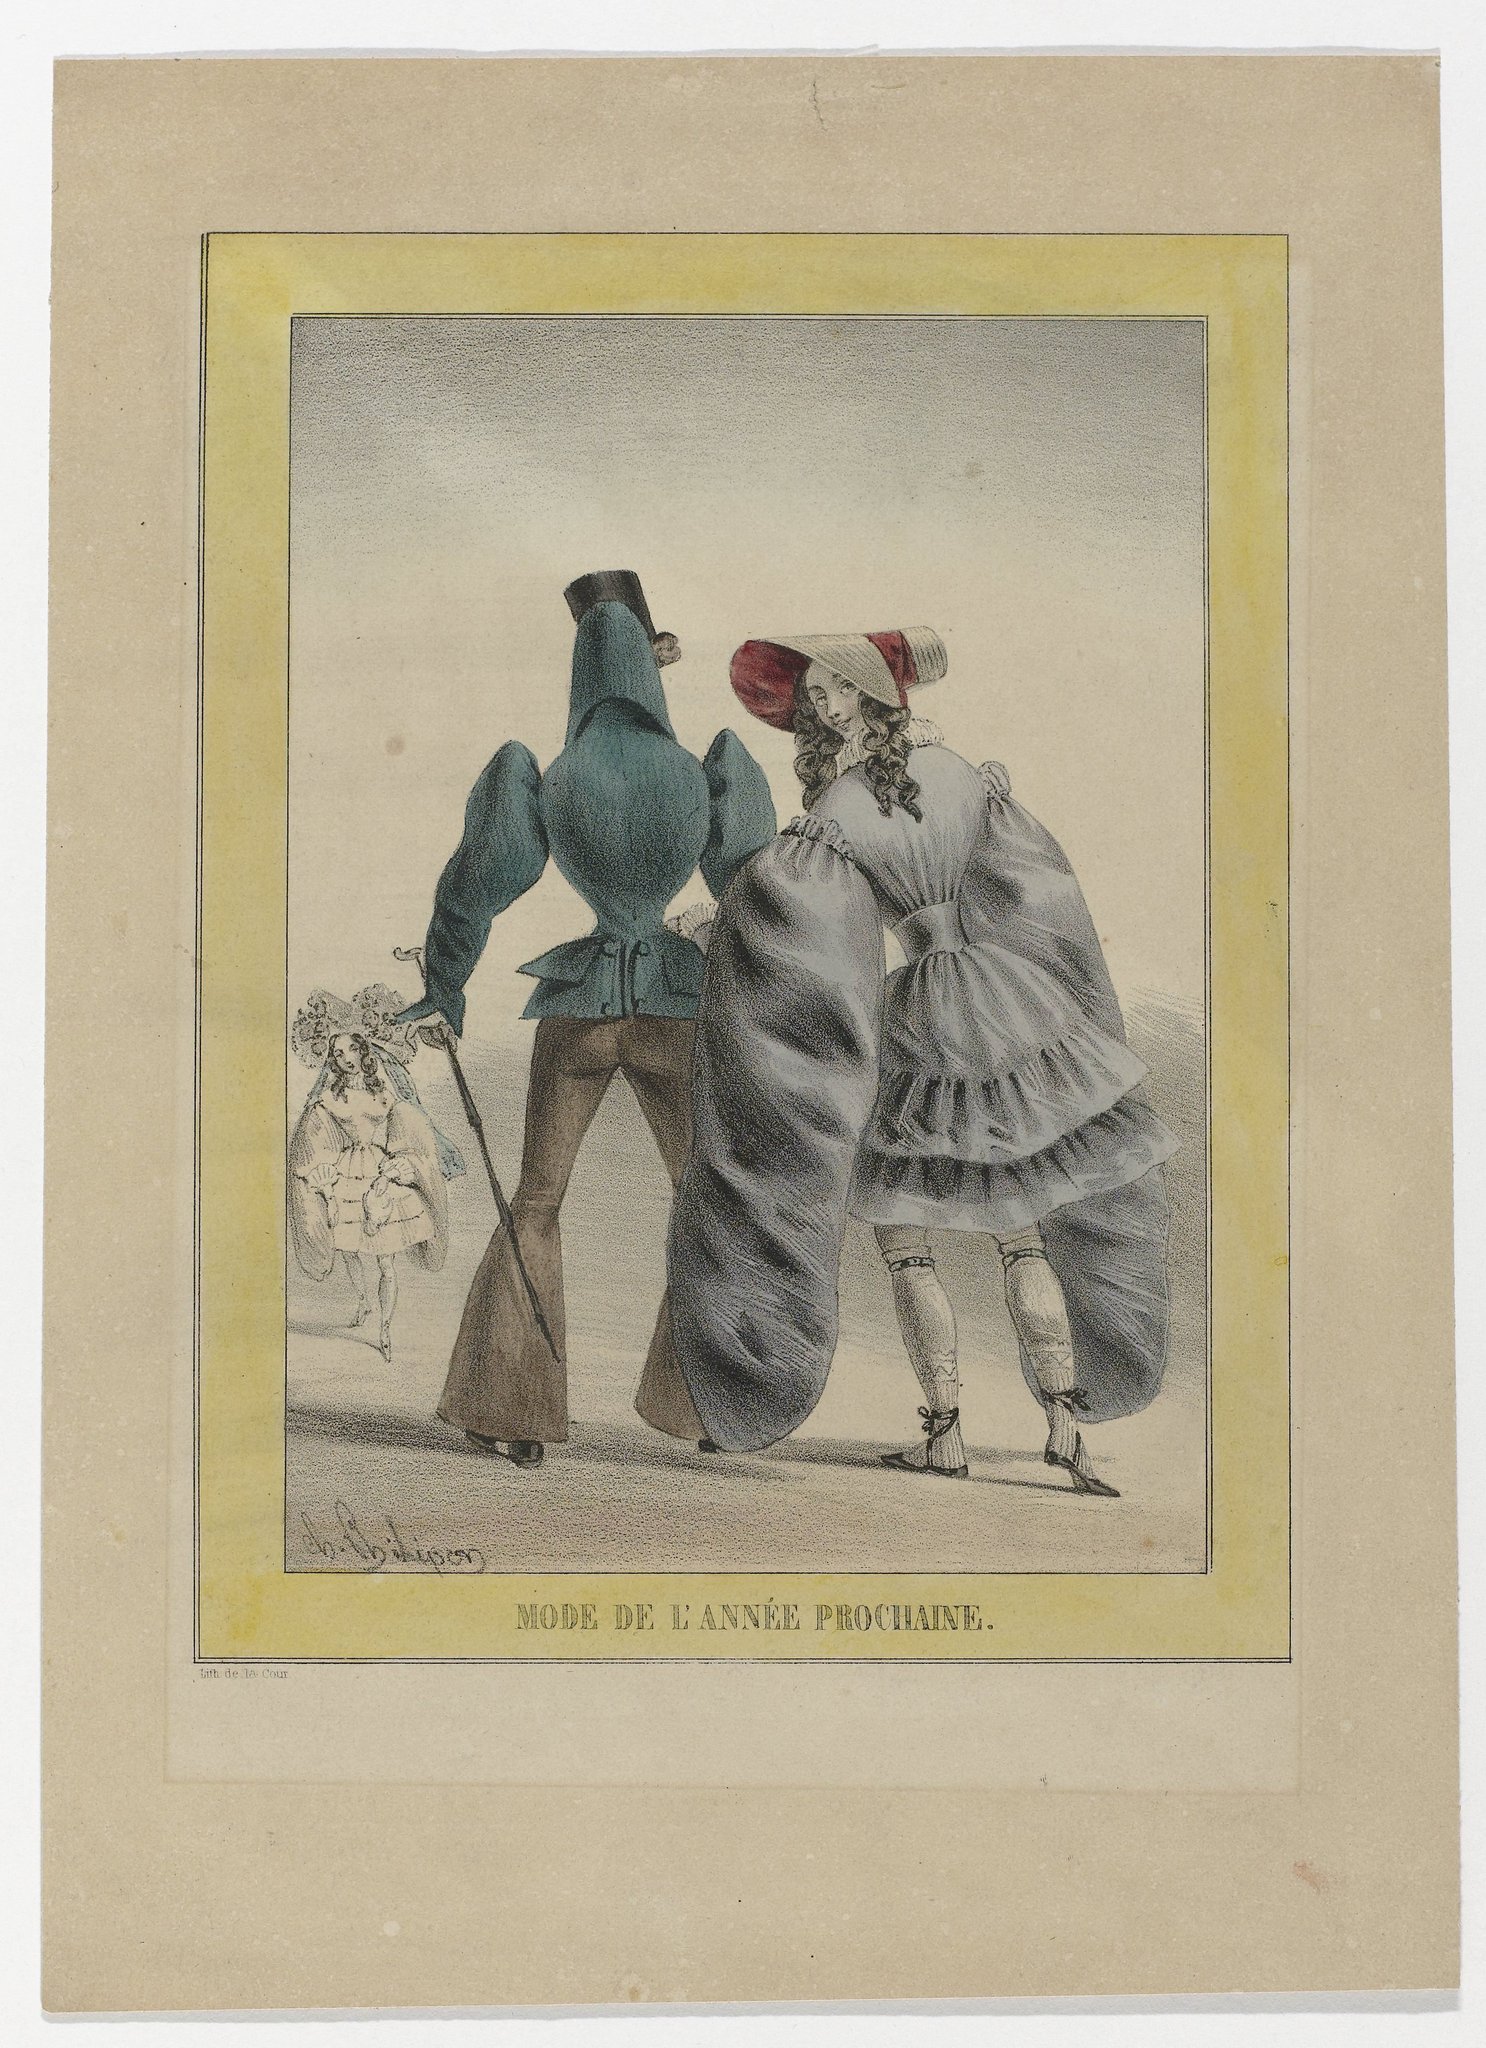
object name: caricature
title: Mode de l'année prochaine, ca. 1830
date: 1829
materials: paper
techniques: hand coloring, lithograph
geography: brussels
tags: trousers, breeches (+ men's clothes), coat (+ men's clothes), fashion plates, head-gear: hat (+ women's clothes), stockings, socks (+ women's clothes), walking arm in arm, sleeves (+ women's clothes)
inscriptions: caption: ‘MODE DE L'ANNÉE PROCHAINE.’